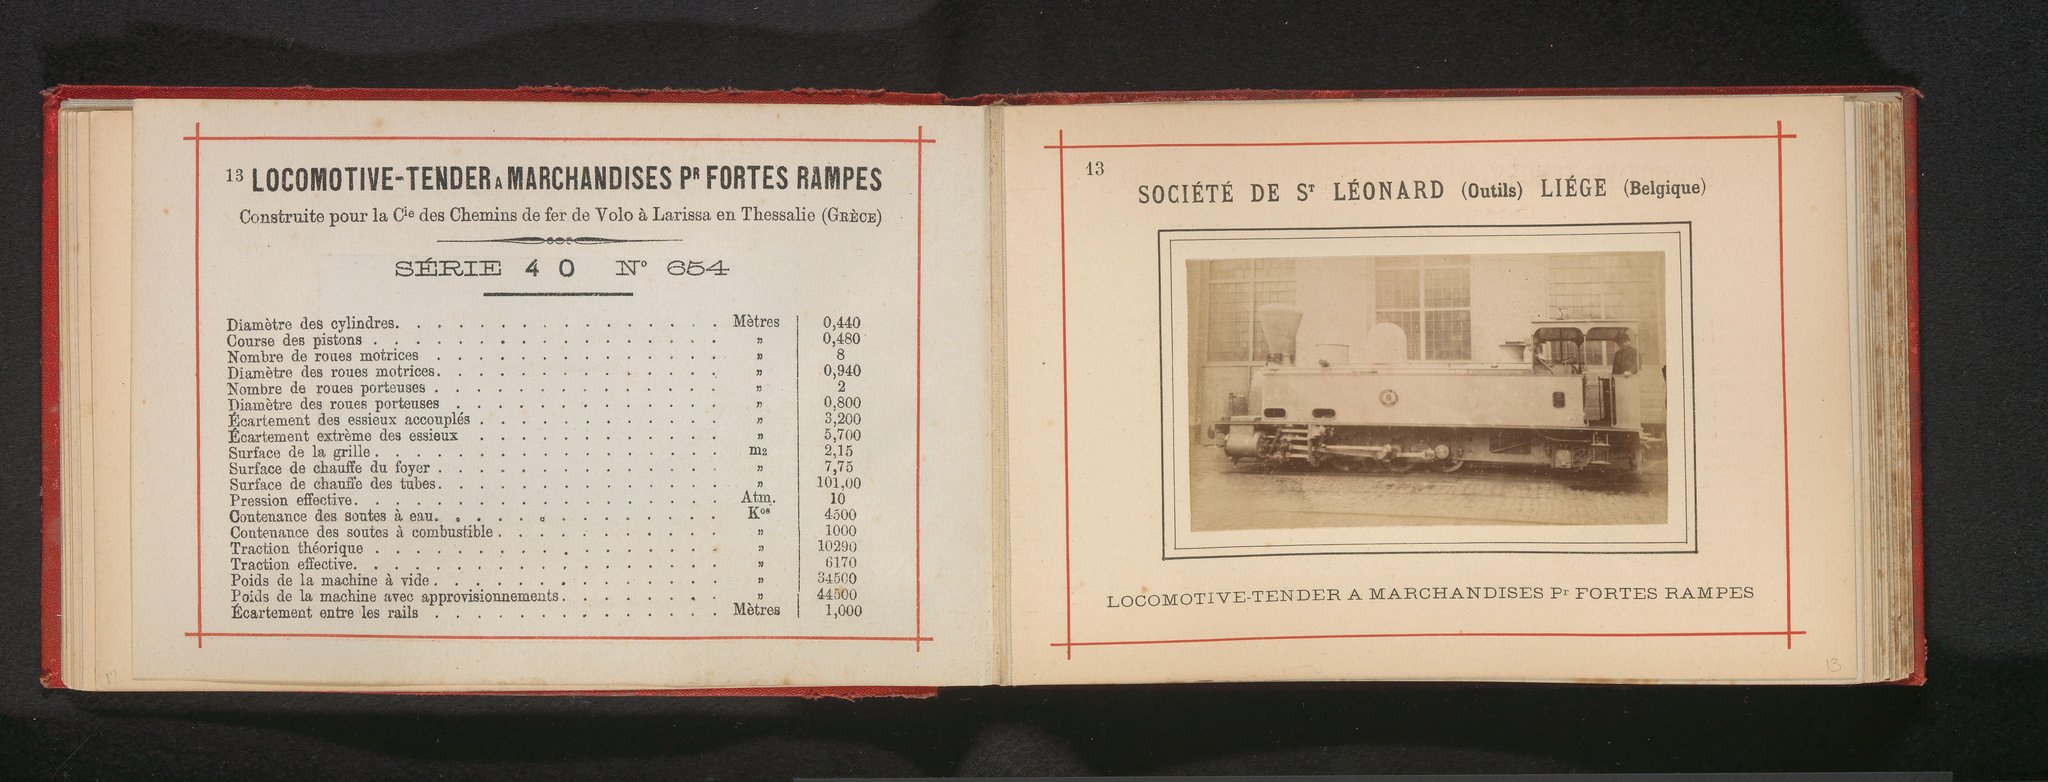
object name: photograph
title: Locomotive-tender a marchandises pr fortes rampes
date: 1880-1885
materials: photographic support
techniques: albumen print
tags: locomotive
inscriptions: inscription: ‘Société de St. Léonard (Outils) Liége (Belgique)’